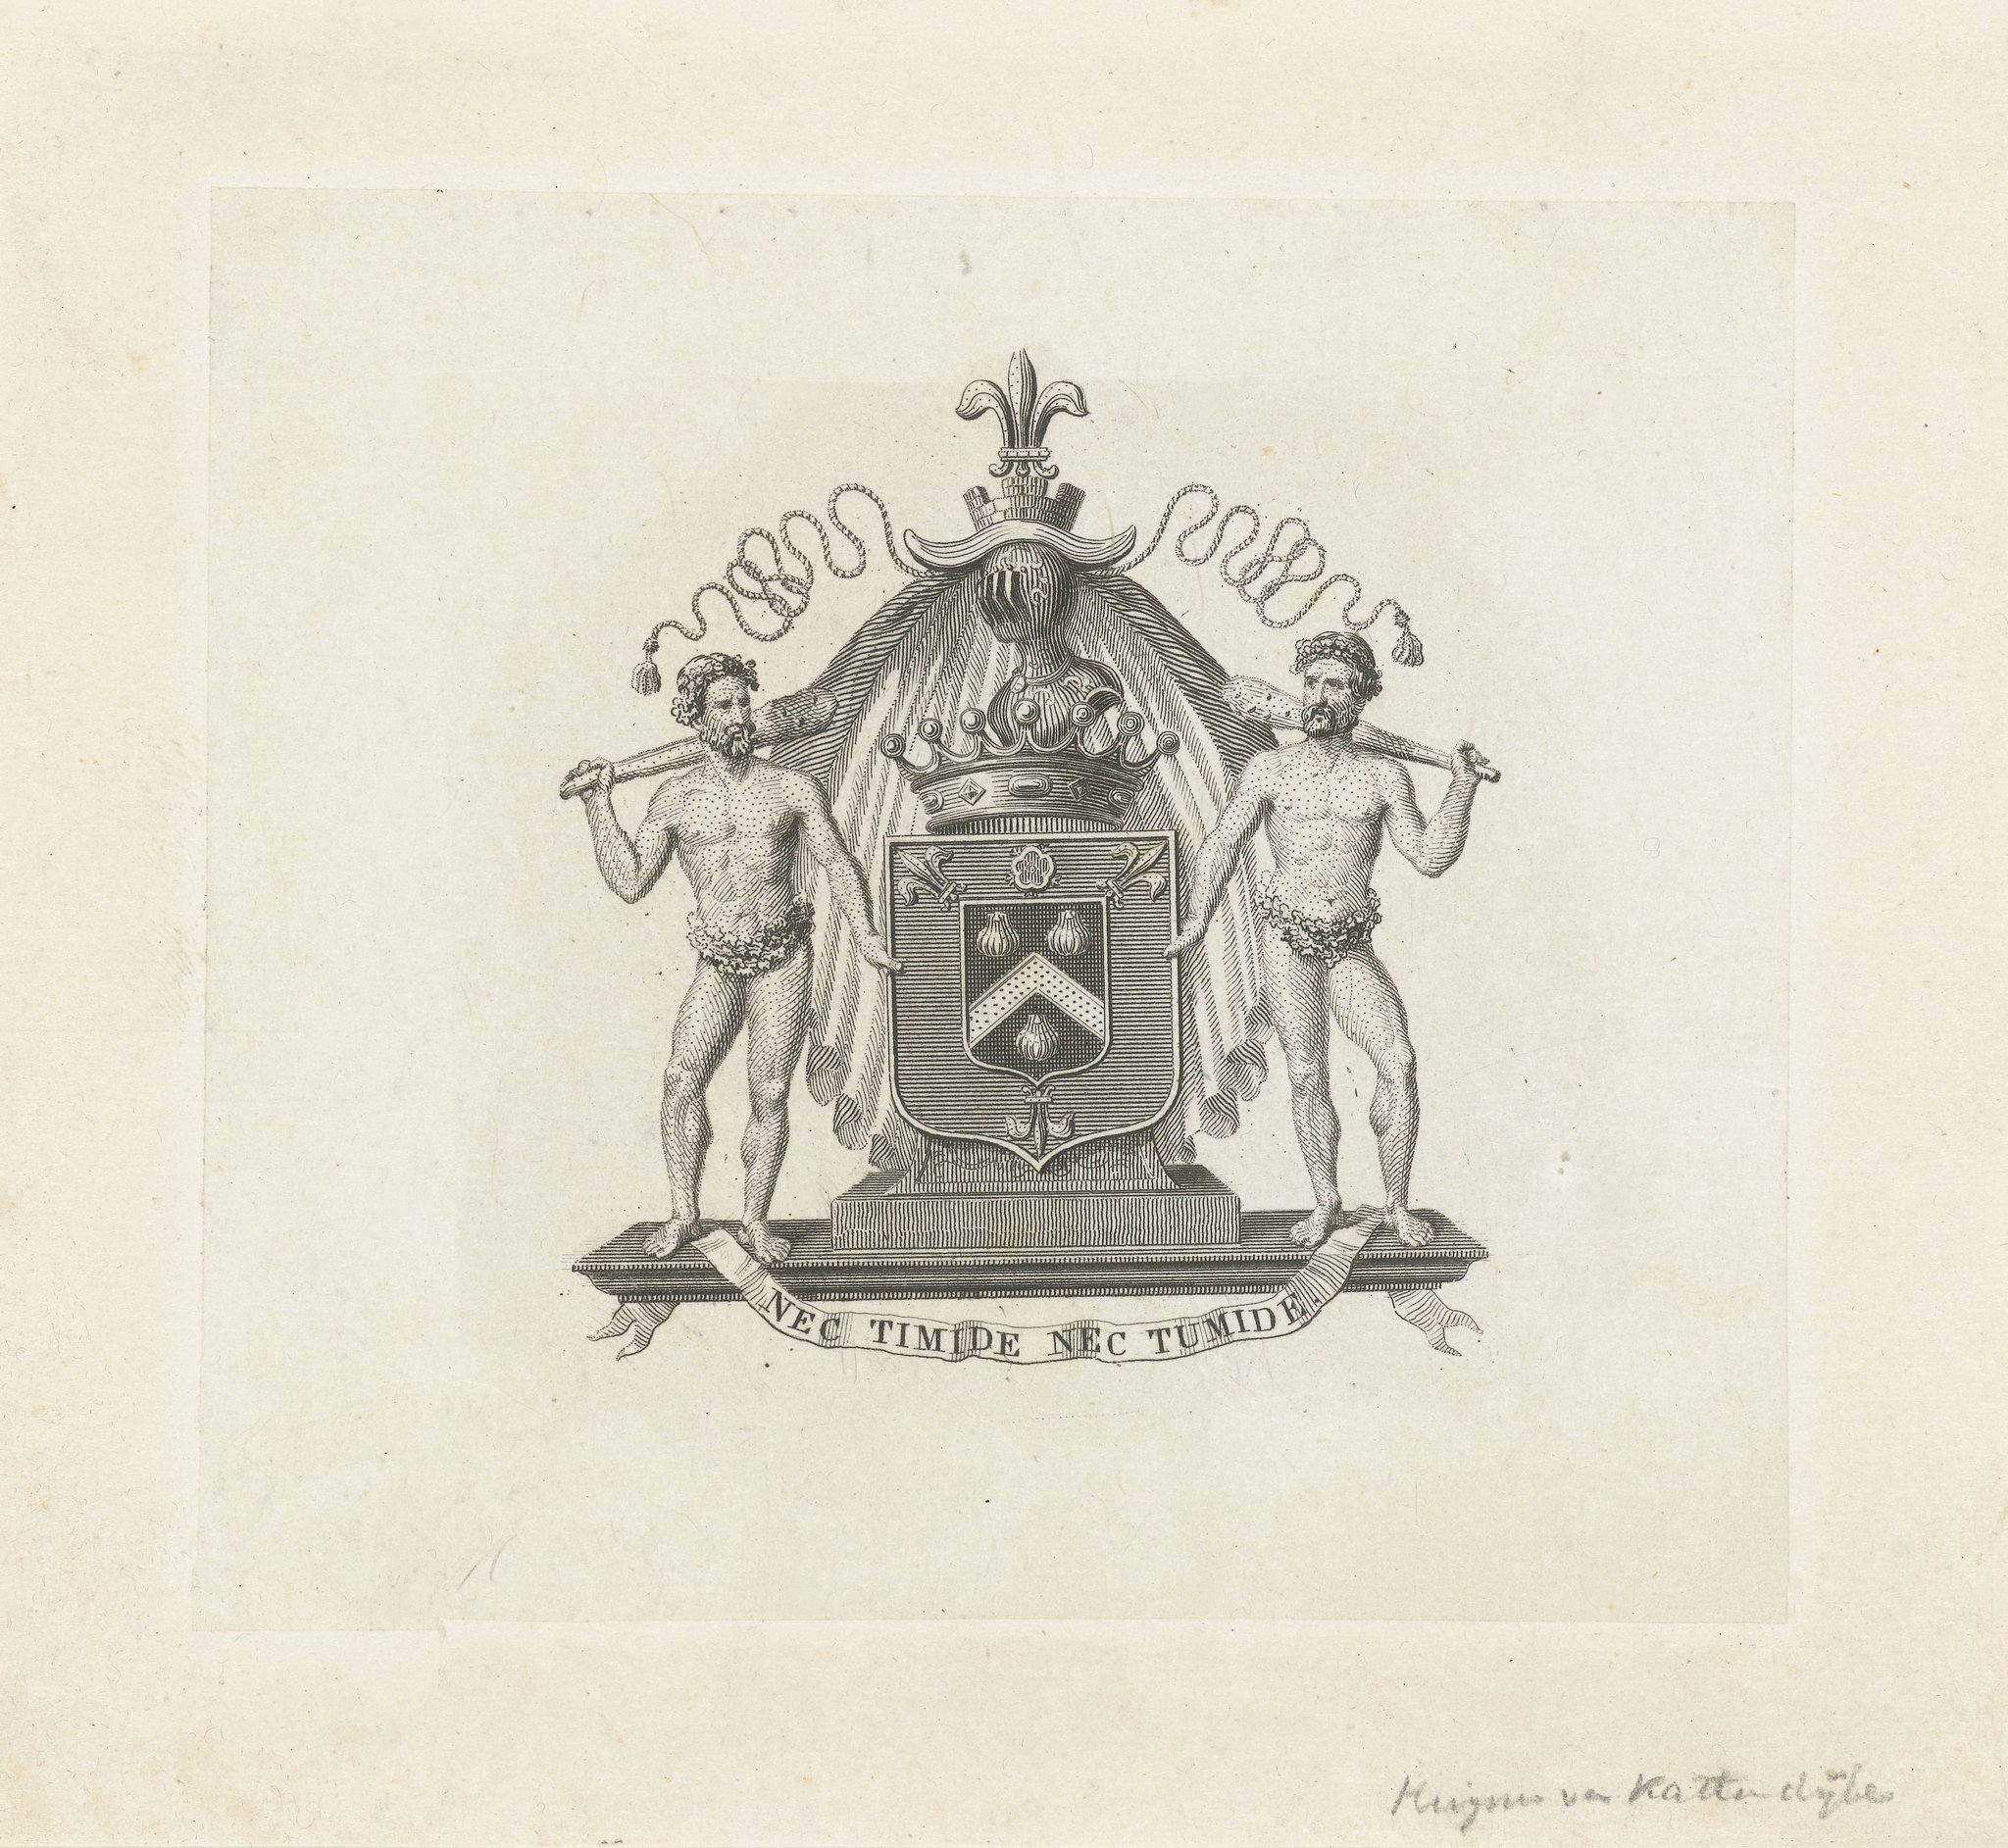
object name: print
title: Wapen van de Zeeuwse familie Huyssen van Kattendijke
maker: henricus wilhelmus couwenberg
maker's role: draughtsman, print maker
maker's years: 1814-1845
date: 1830-1845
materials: paper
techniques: etching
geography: amsterdam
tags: coat of arms (as symbol of the state, etc.)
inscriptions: collector's mark: Lugt 2228